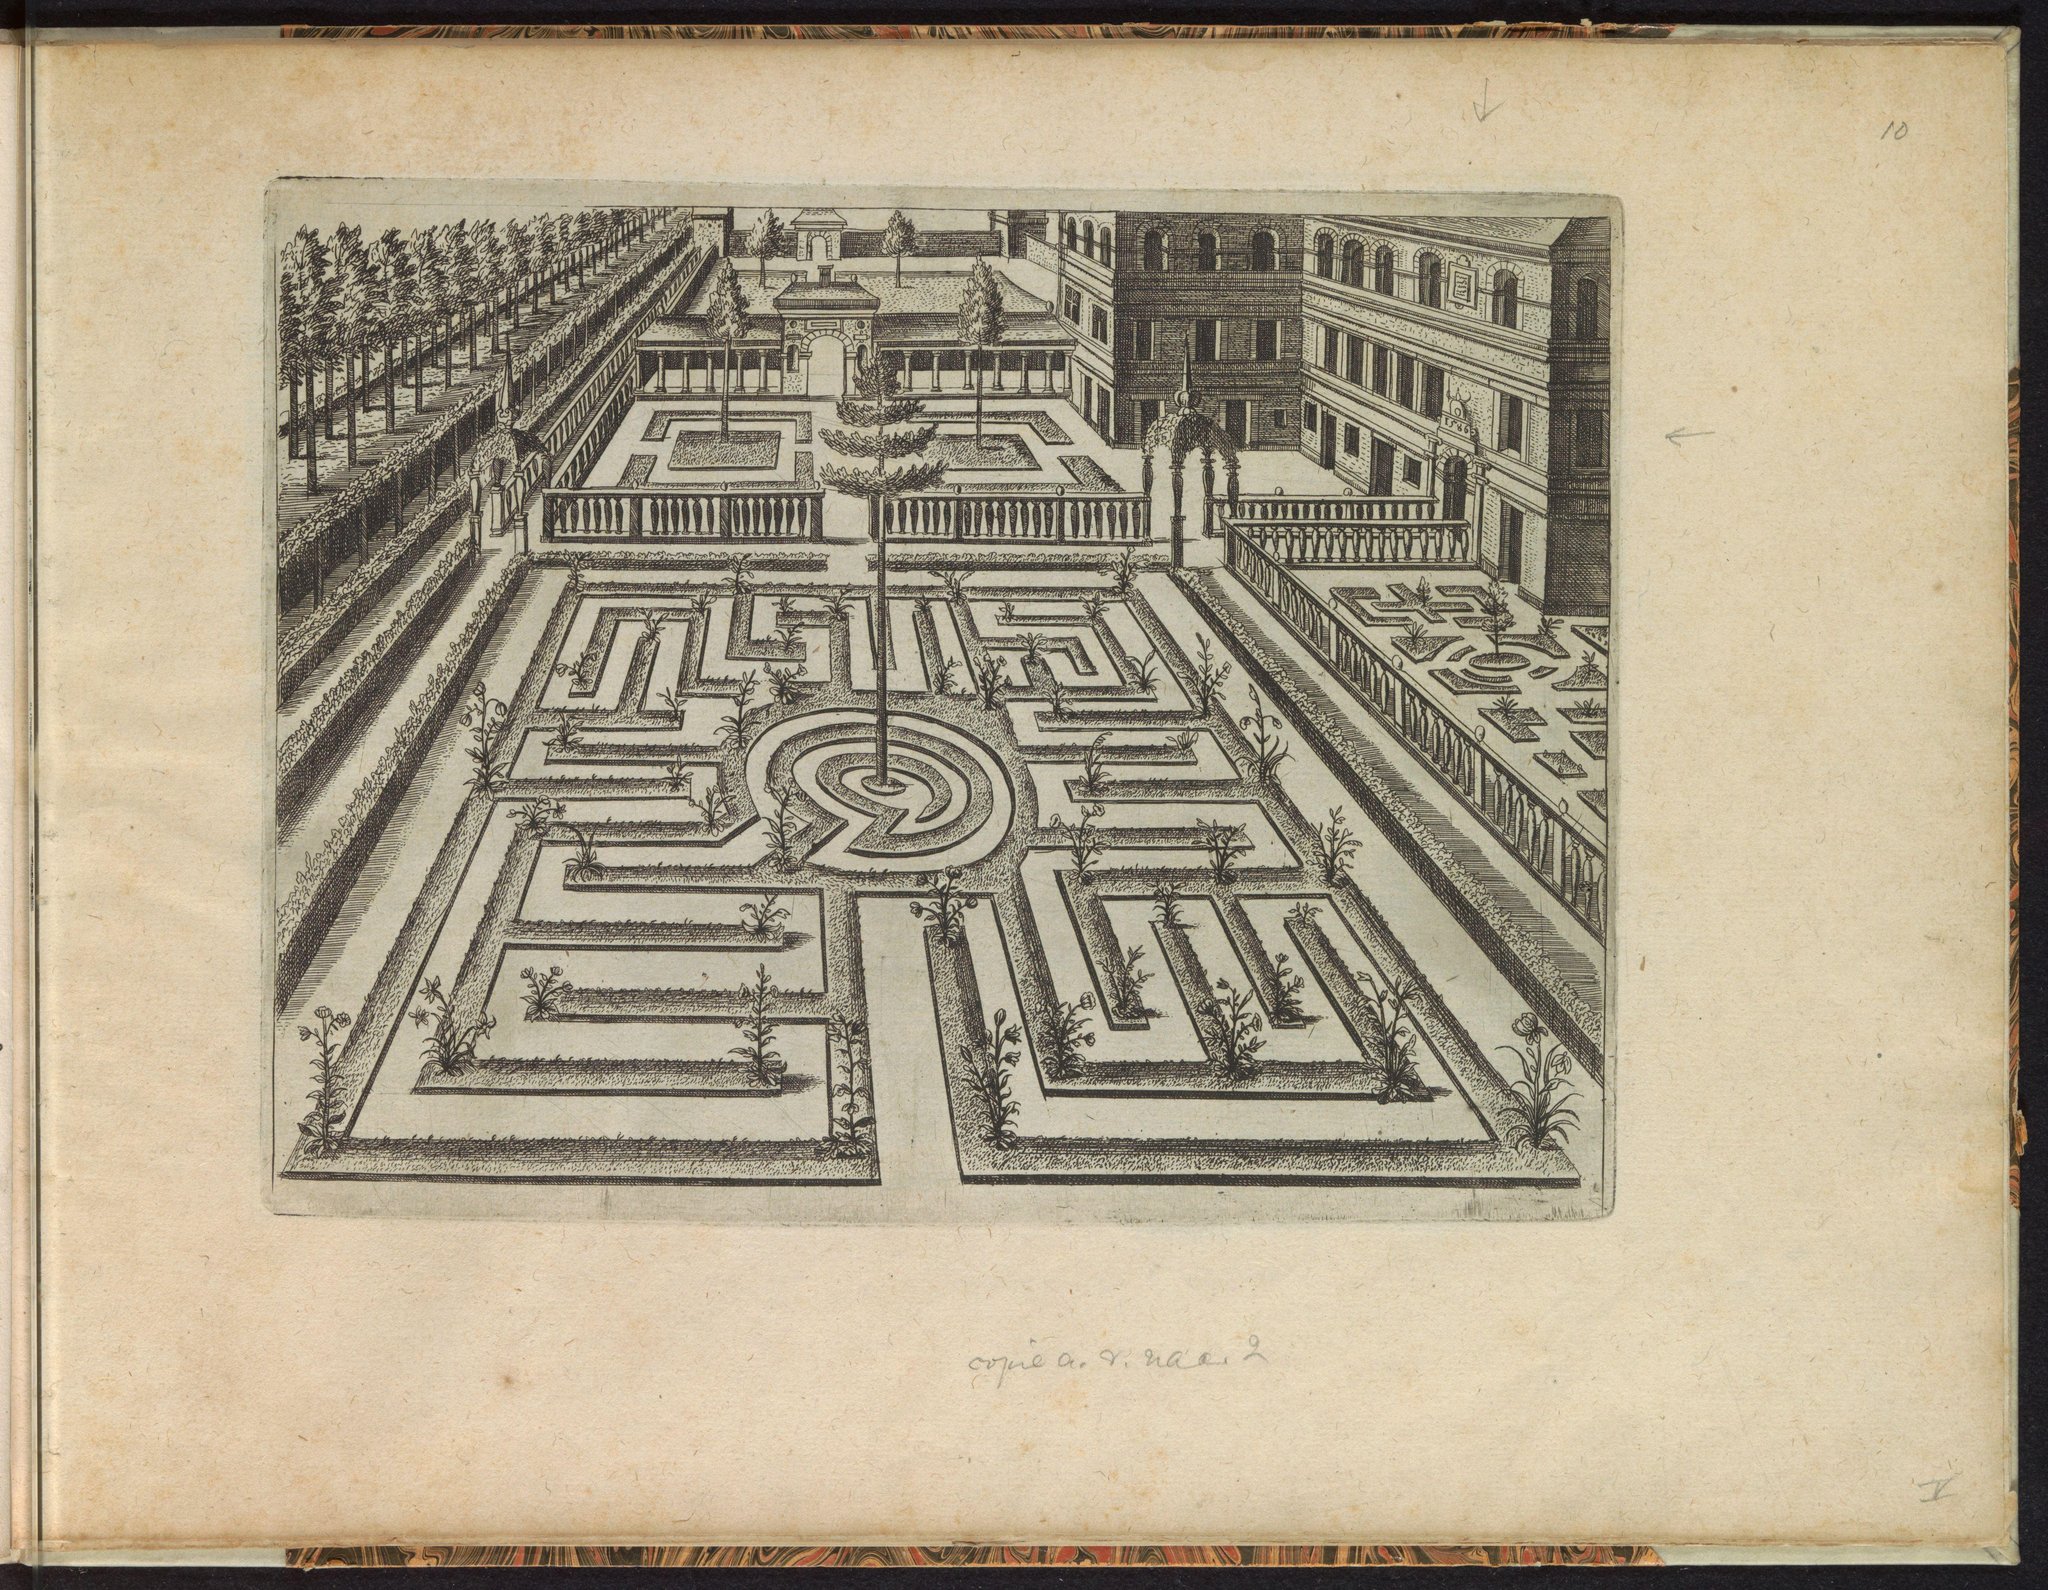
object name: album leaf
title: Tuinen (8-bladige reeks)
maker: johann bussemacher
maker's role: print maker, printer, publisher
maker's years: -1627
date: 1615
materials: paper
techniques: etching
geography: cologne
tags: garden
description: Een tuin met een parterre met in het centrum een spiraal en een boom. De prent maakt deel uit van een album.